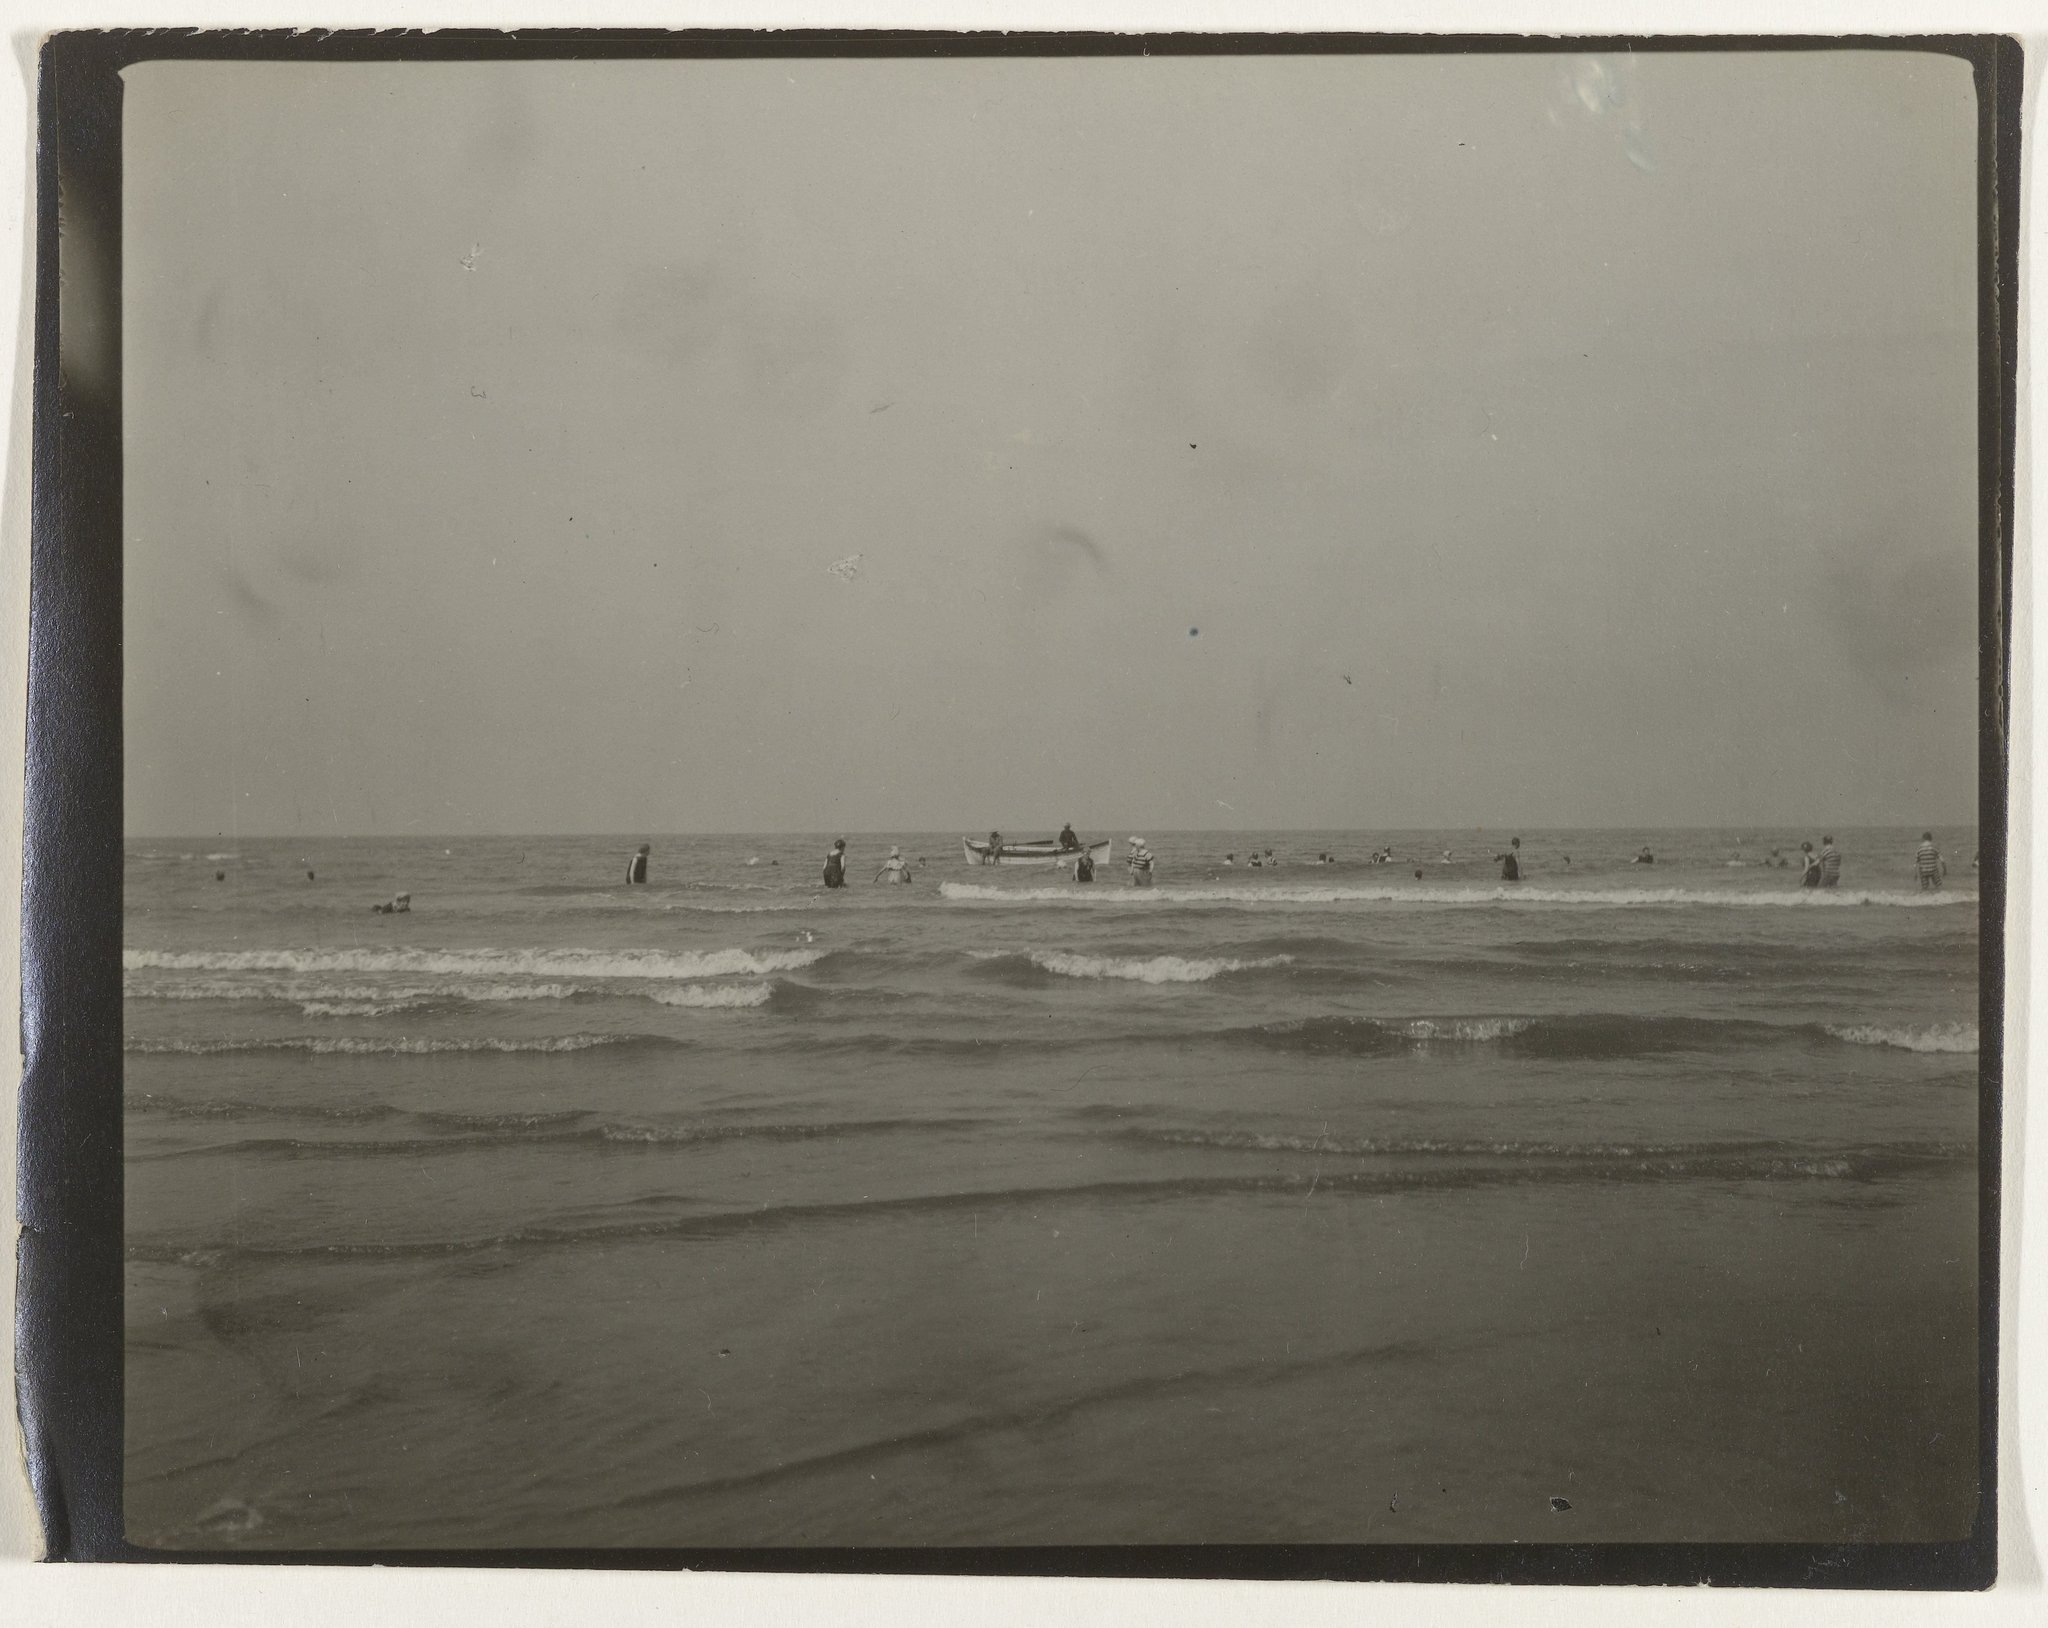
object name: photograph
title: Zwemmende mensen in zee (Noordzeekust), Nederland of Duitsland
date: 1900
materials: paper, photographic support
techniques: gelatin silver print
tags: beach (as place of recreation), netherlands, germany